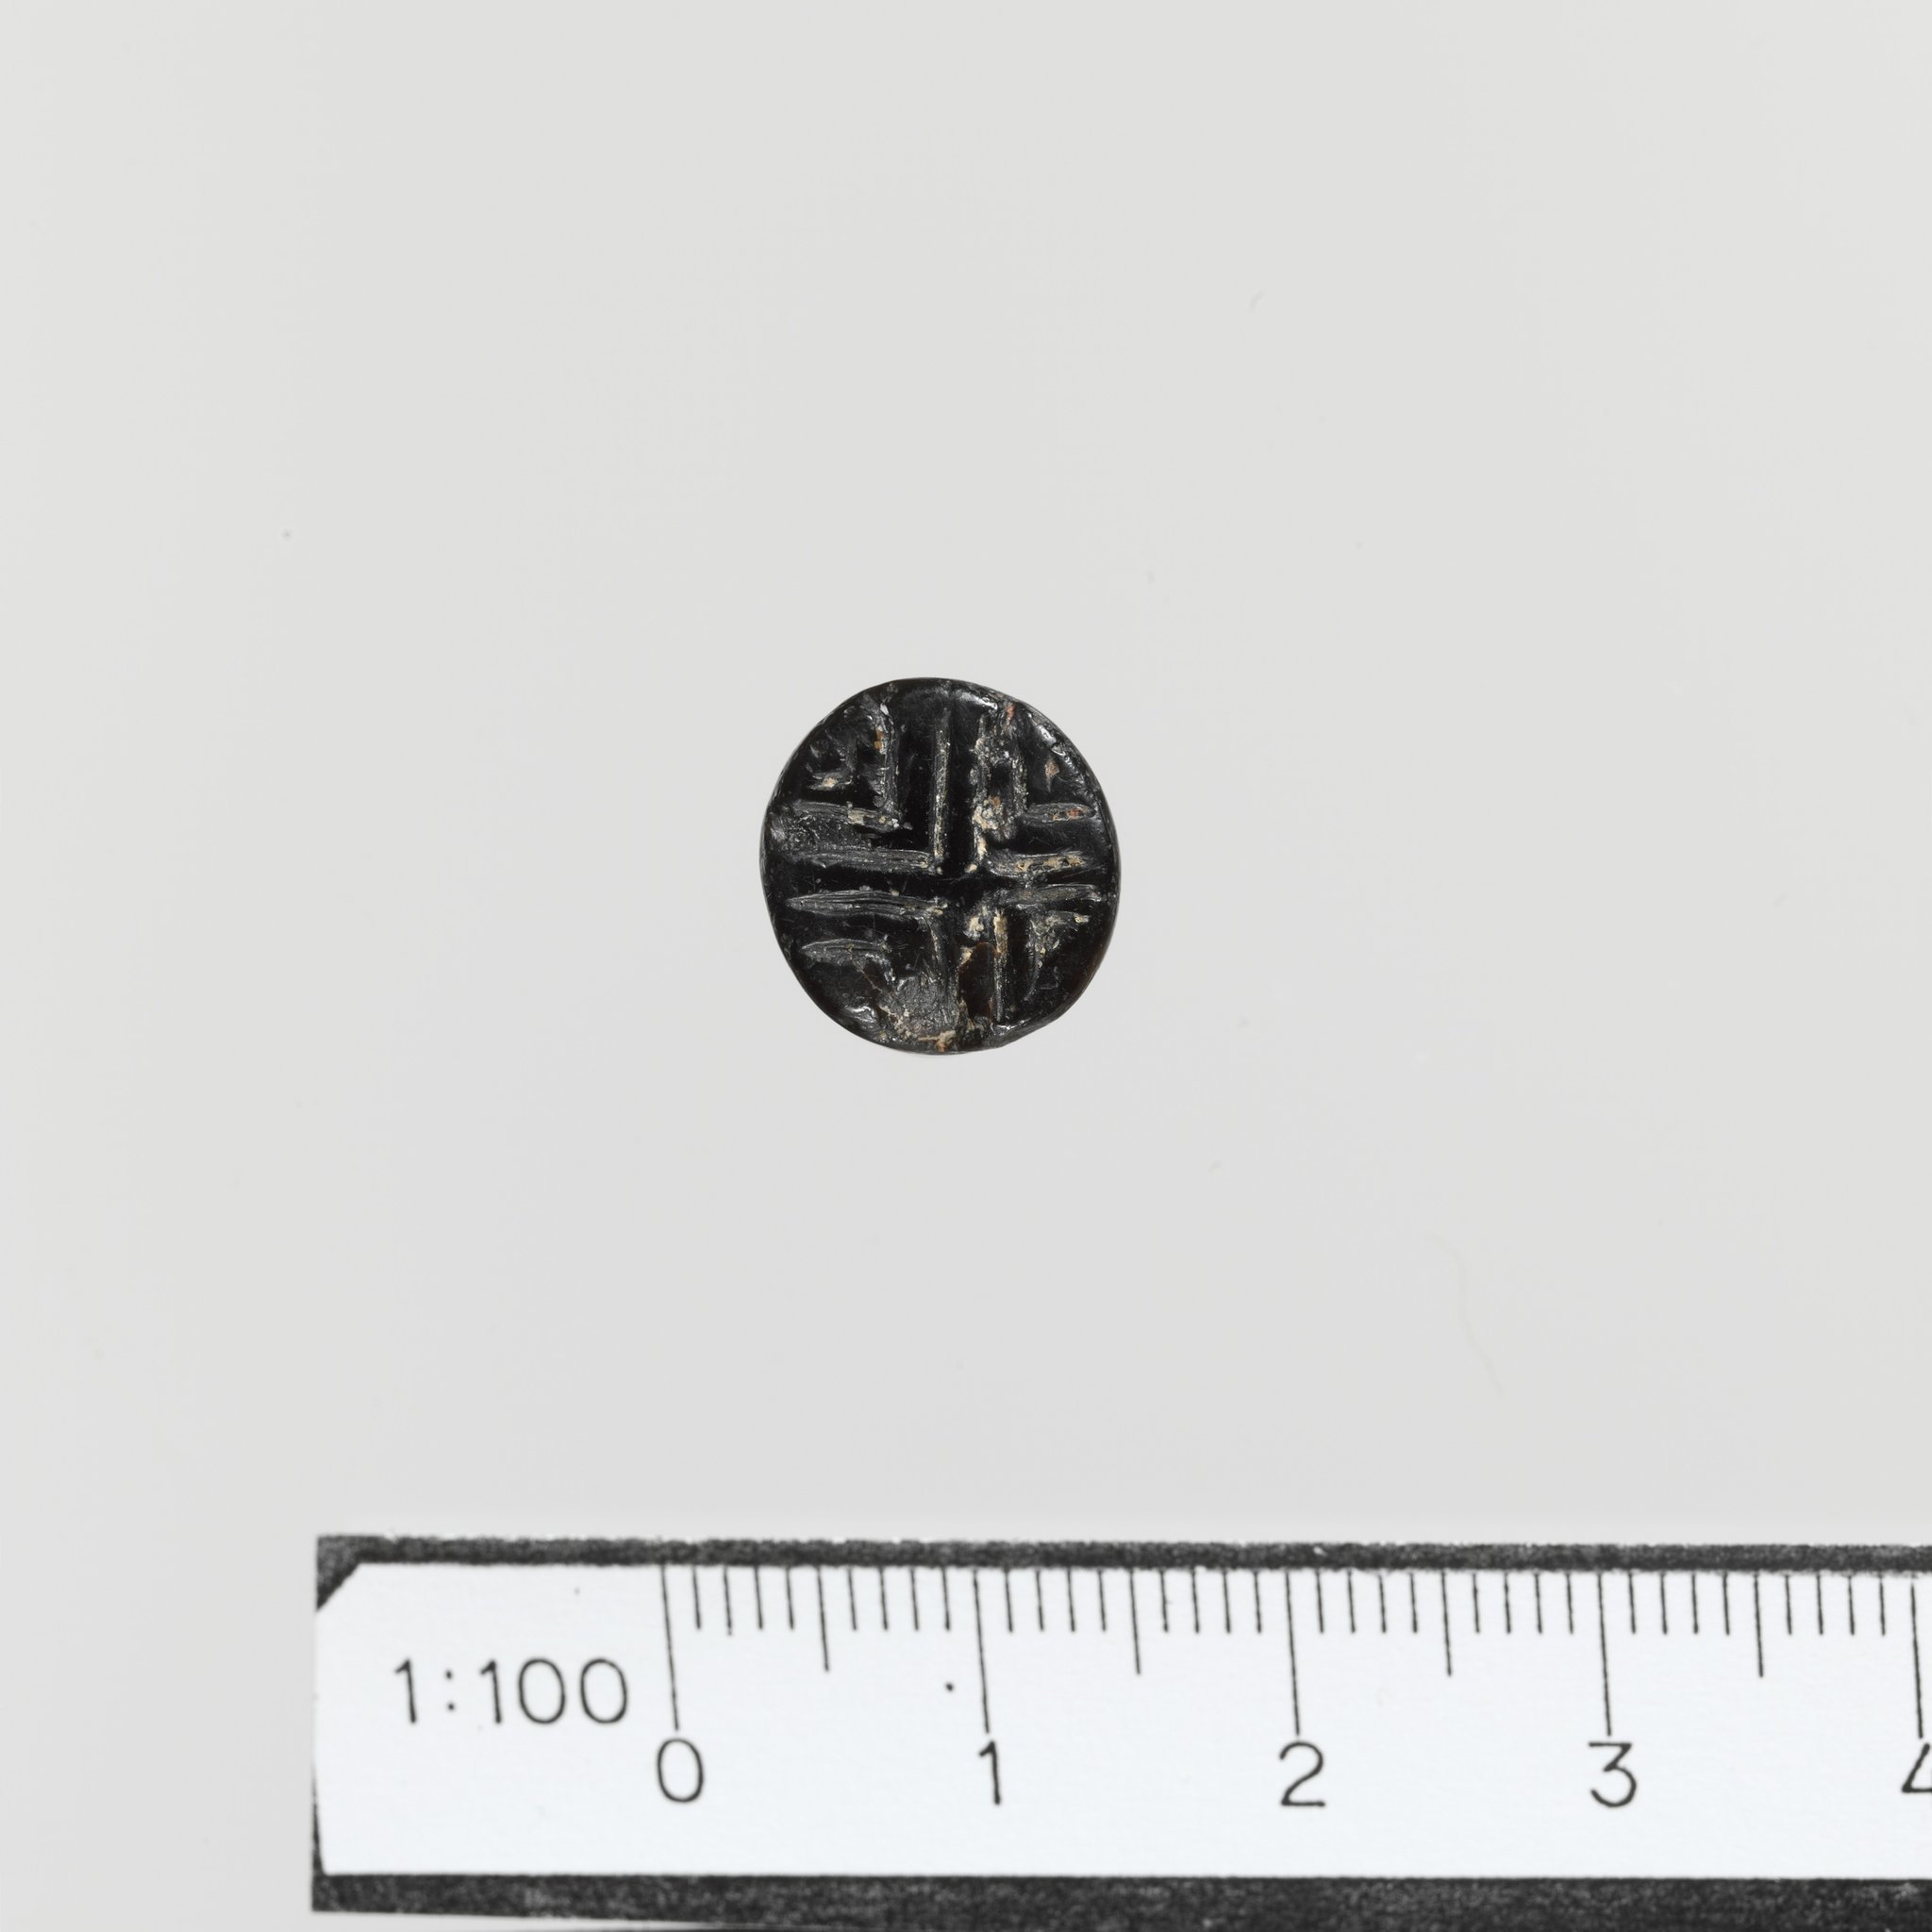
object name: seal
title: Steatite cylindrical seal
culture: minoan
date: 2400-2200 BCE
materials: stone